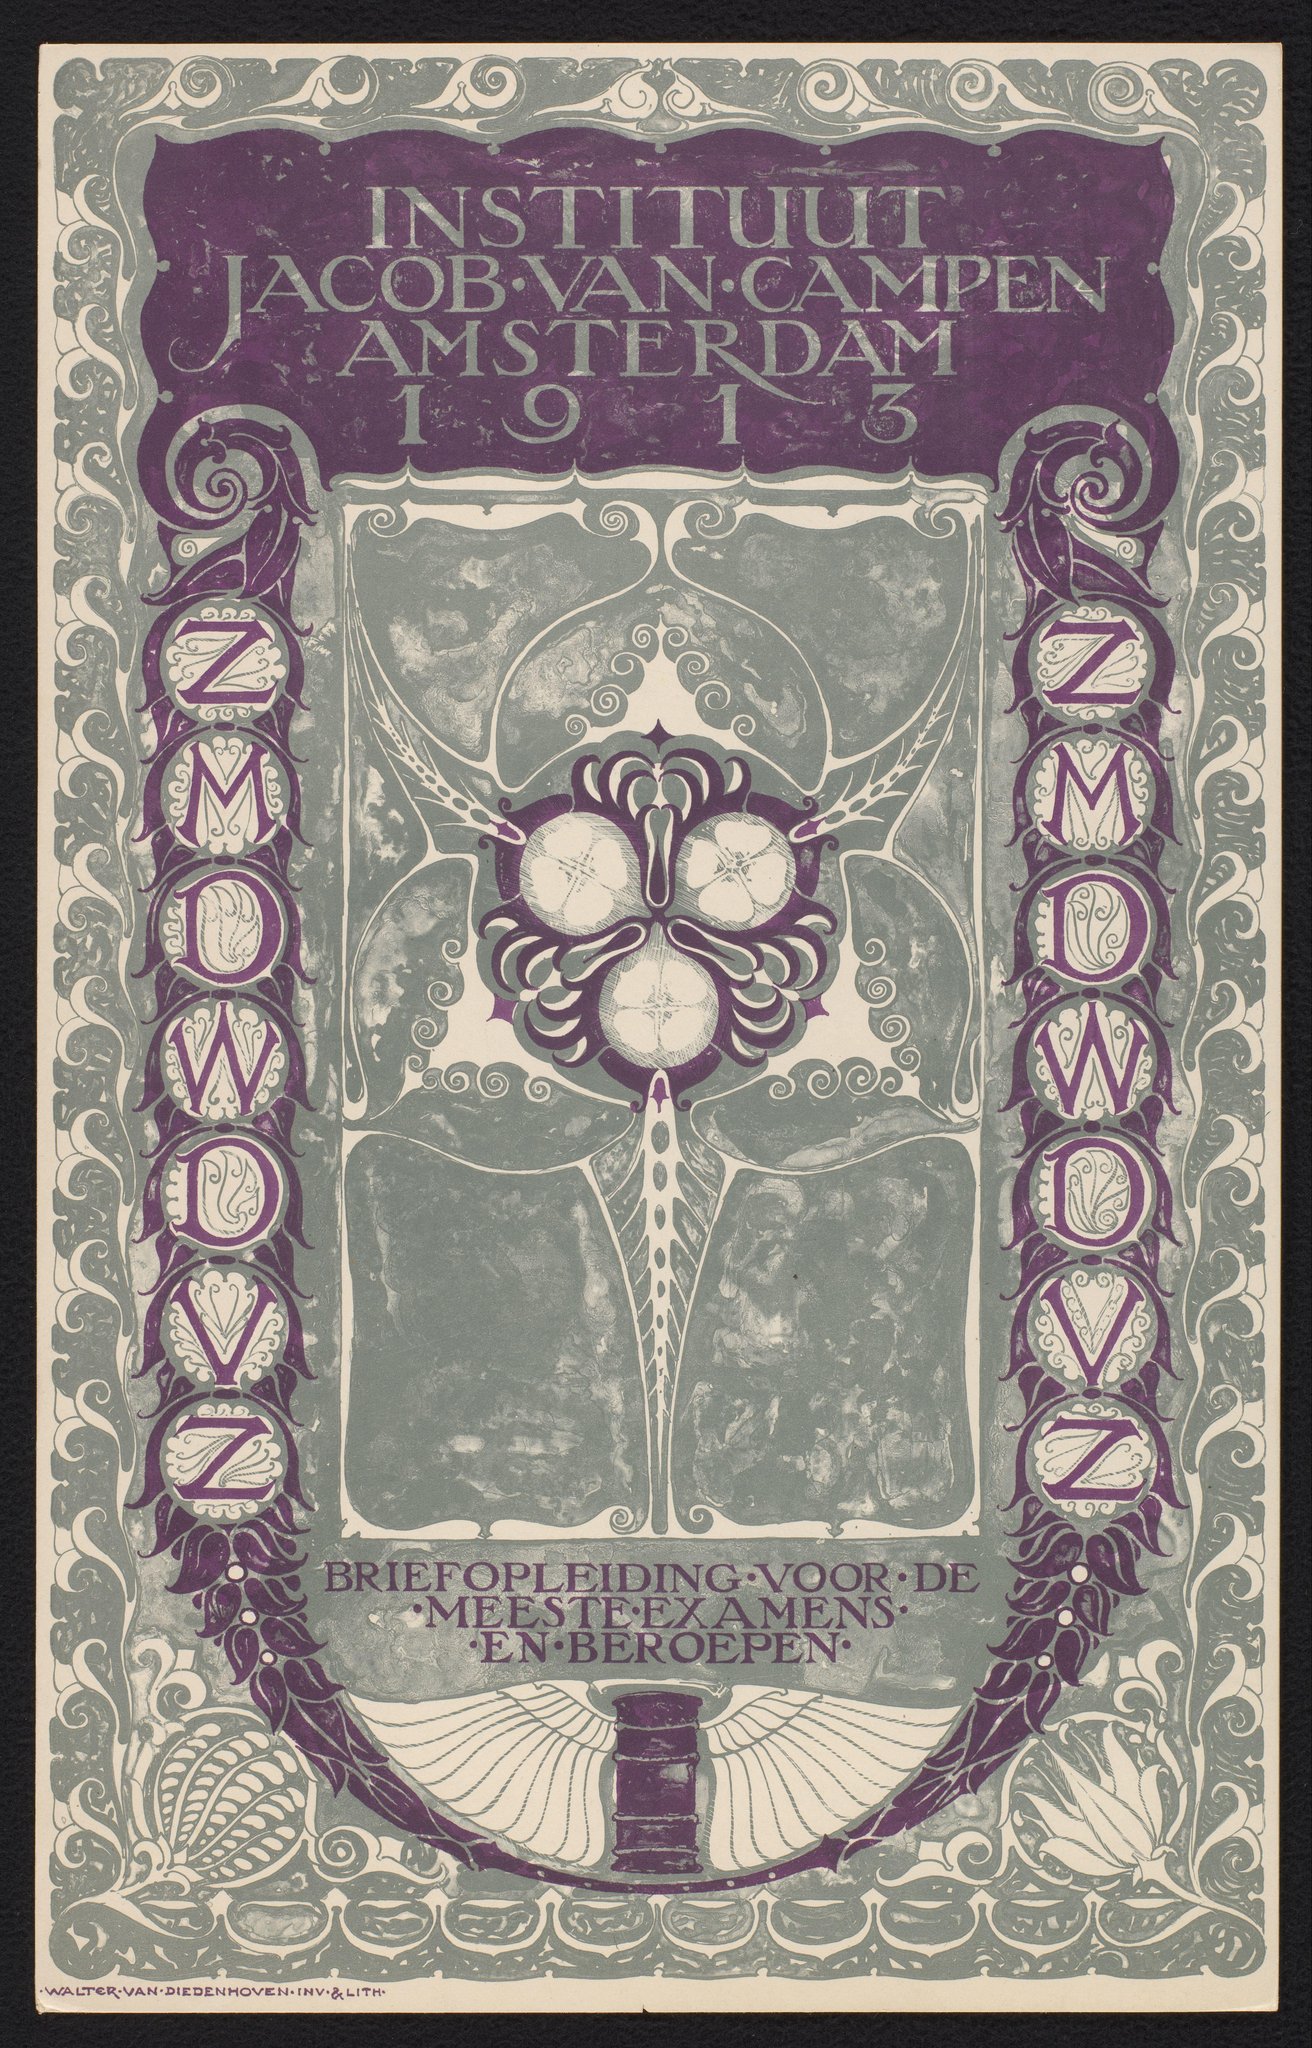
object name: calendar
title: Kalenderschild van een kalender voor 1913 van het Instituut Jacob van Campen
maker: walter van diedenhoven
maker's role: print maker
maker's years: 1886-1915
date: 1912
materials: paper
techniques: lithograph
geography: amsterdam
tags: calendar, almanac, ornament derived from plant forms, amsterdam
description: Bovenaan de naam van het instituut. Daaronder afkortingen van de letters van de dagen en onderaan: 'Briefopleiding voor de meeste examens en beroepen'. Verder voorzien van sierlijke bloemdecoratie.